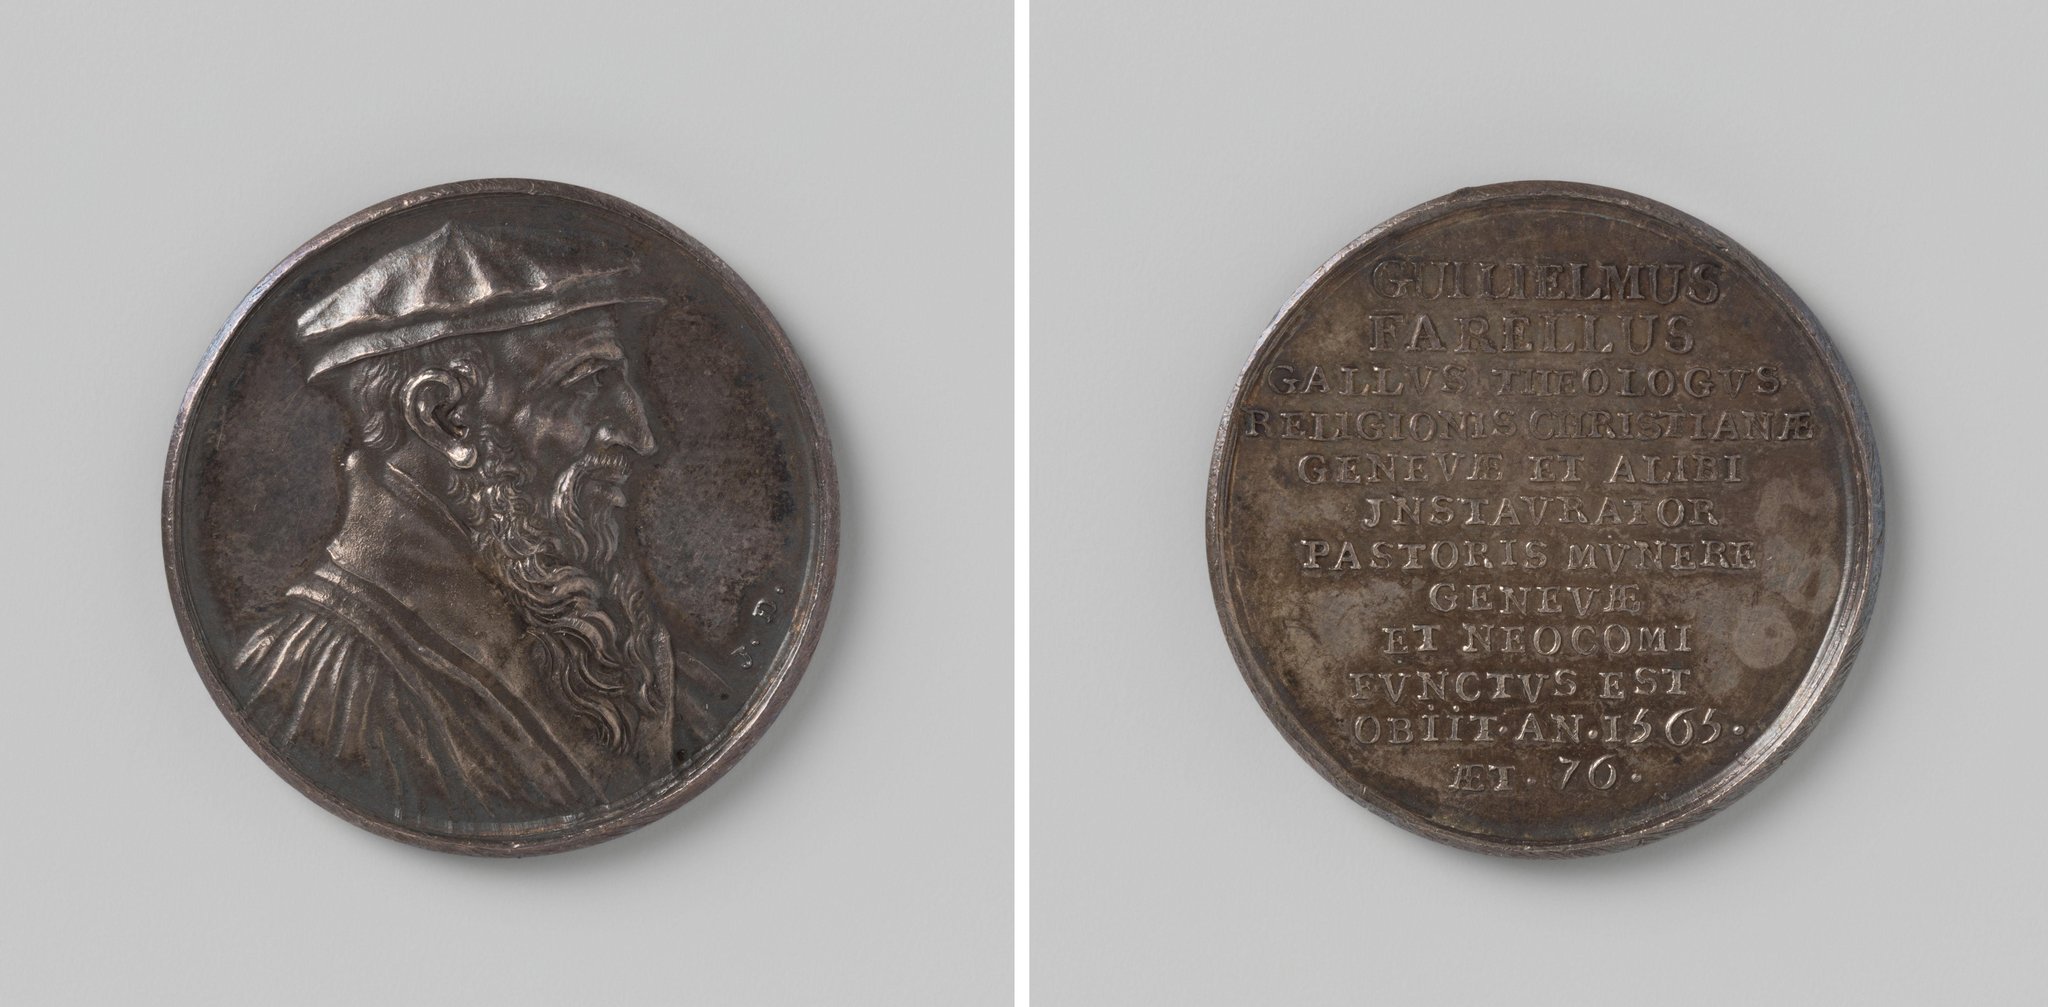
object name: history medal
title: Overlijden van Willem Farel, hervormer in Frankrijk en te Geneve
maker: jean dassier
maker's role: medailleur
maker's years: 1676-1763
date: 1725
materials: silver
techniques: striking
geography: geneva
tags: france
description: Zilveren penning. Voorzijde: borststuk man. Keerzijde: opschrift